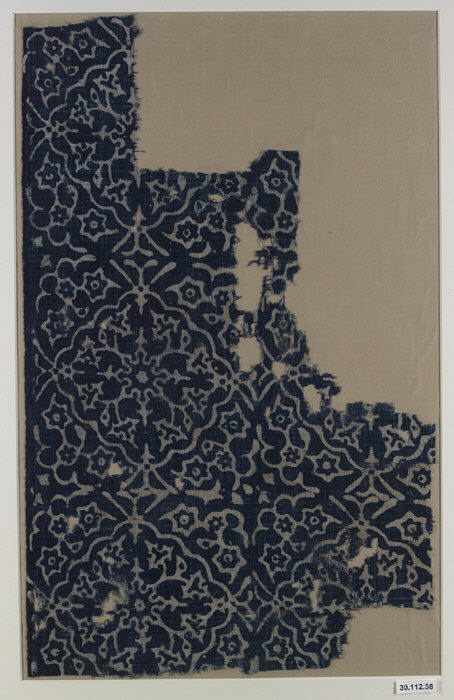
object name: textile fragment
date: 1201-1400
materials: cotton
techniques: dyeing, weave, printing, resist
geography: egypt